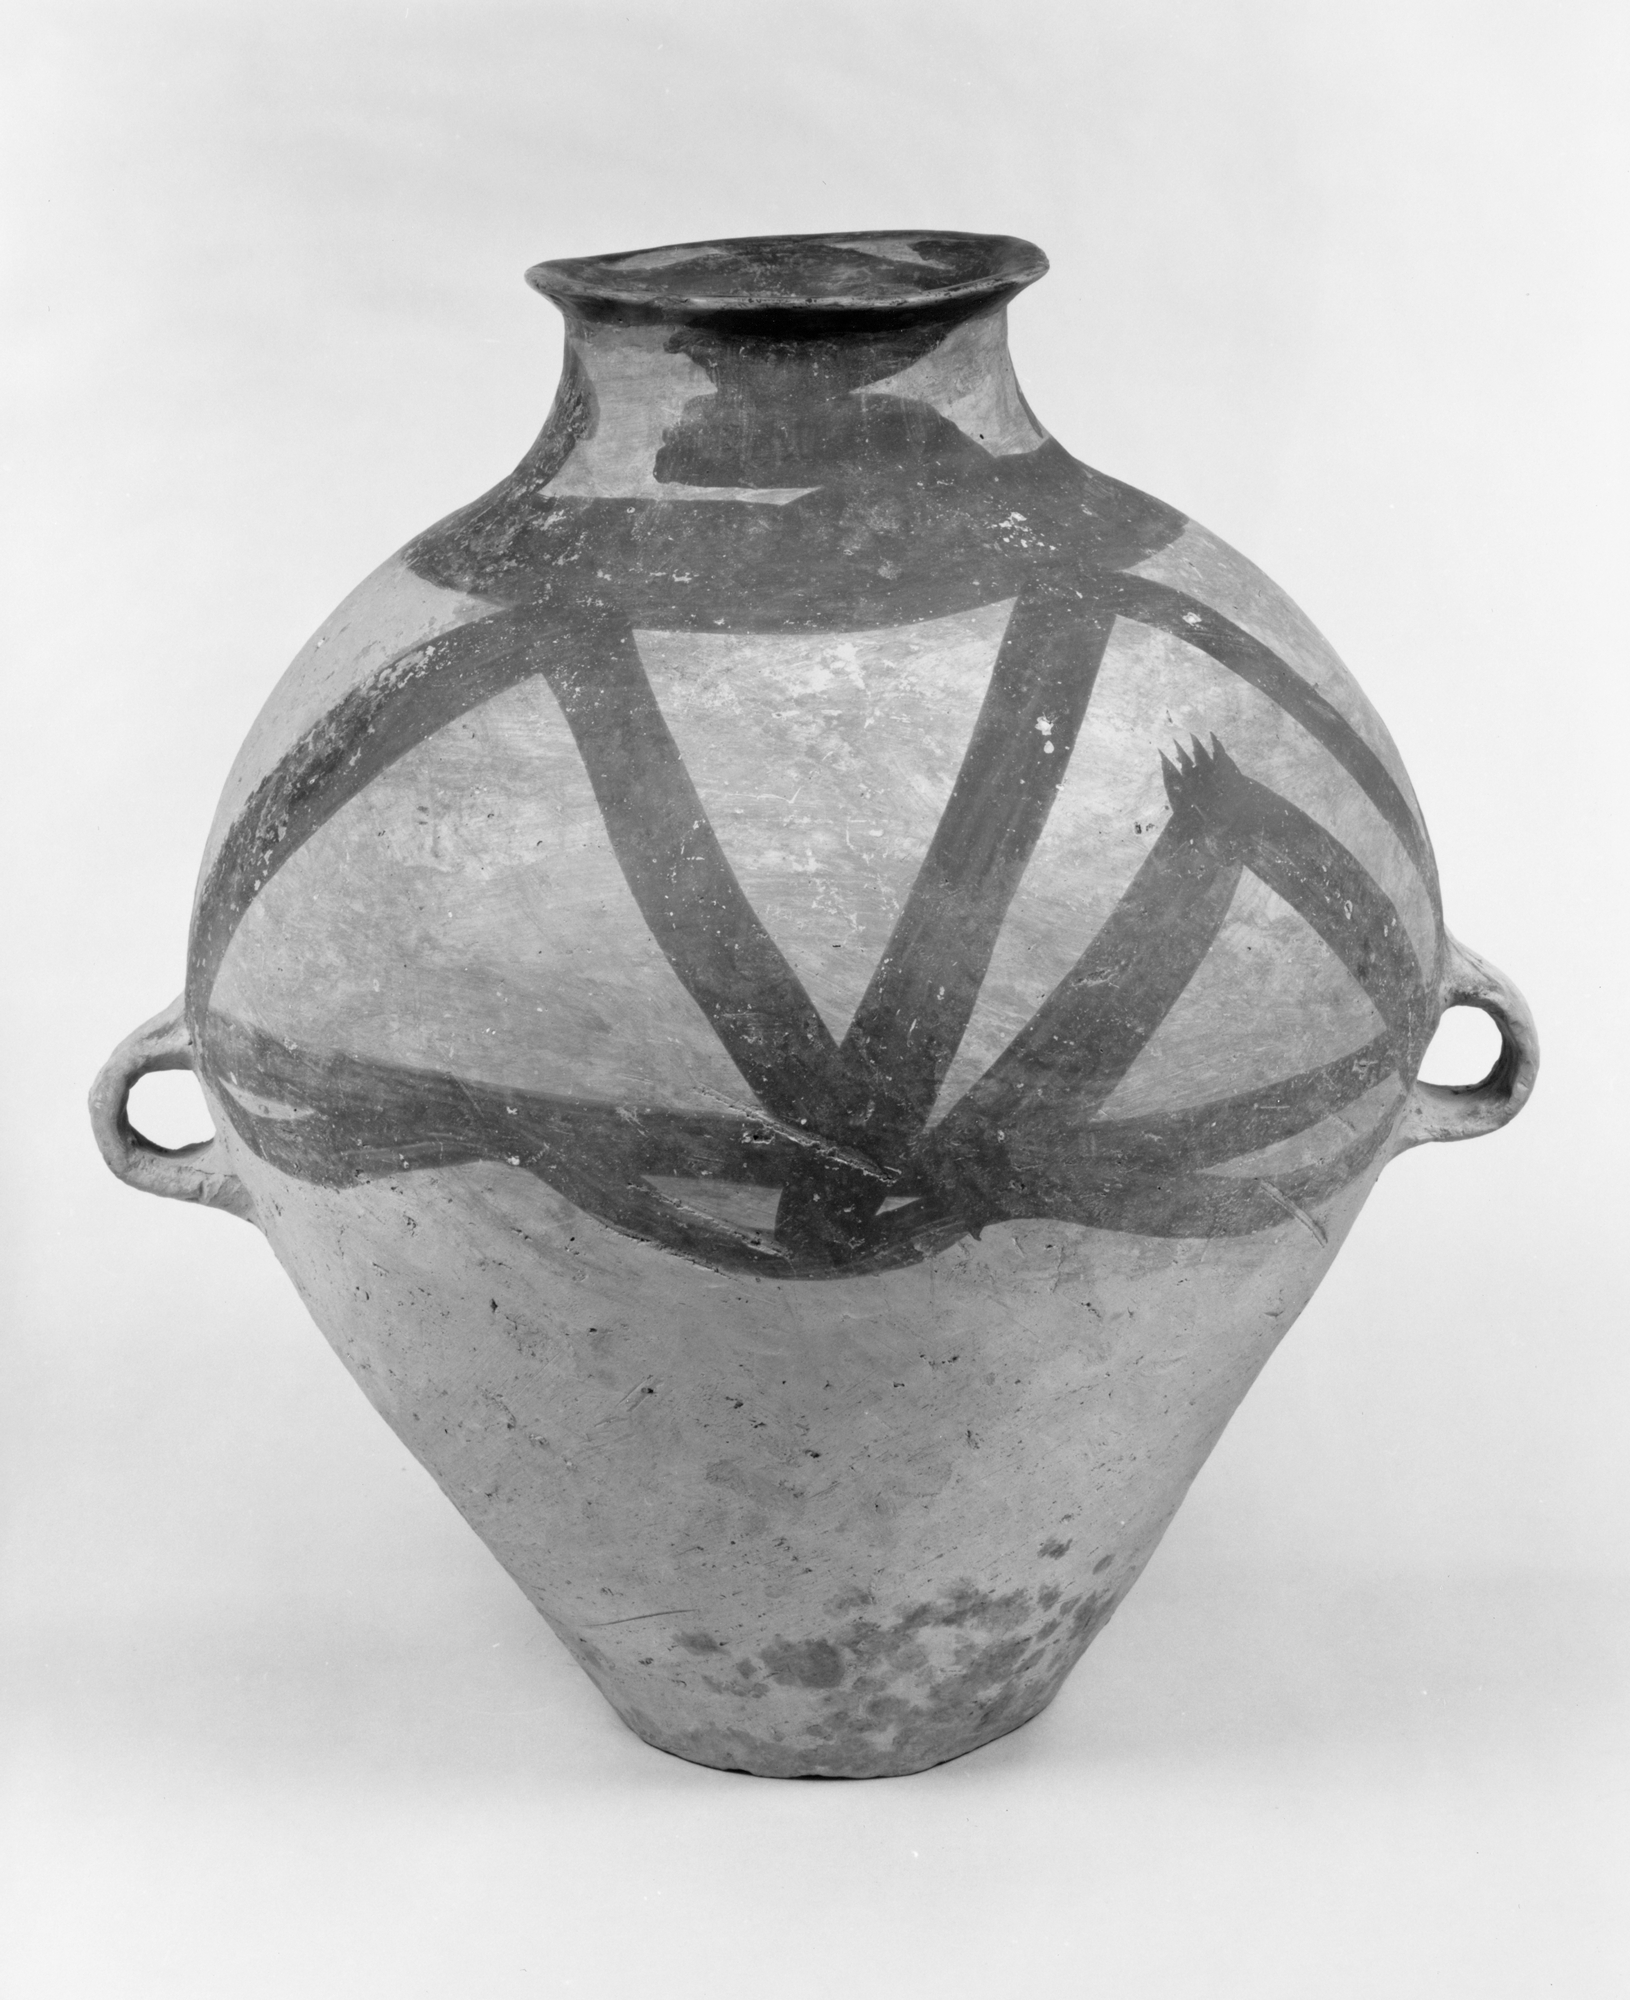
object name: jar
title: Jar (Guan)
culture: chinese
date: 2300-2000 BCE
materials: earthenware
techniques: painting